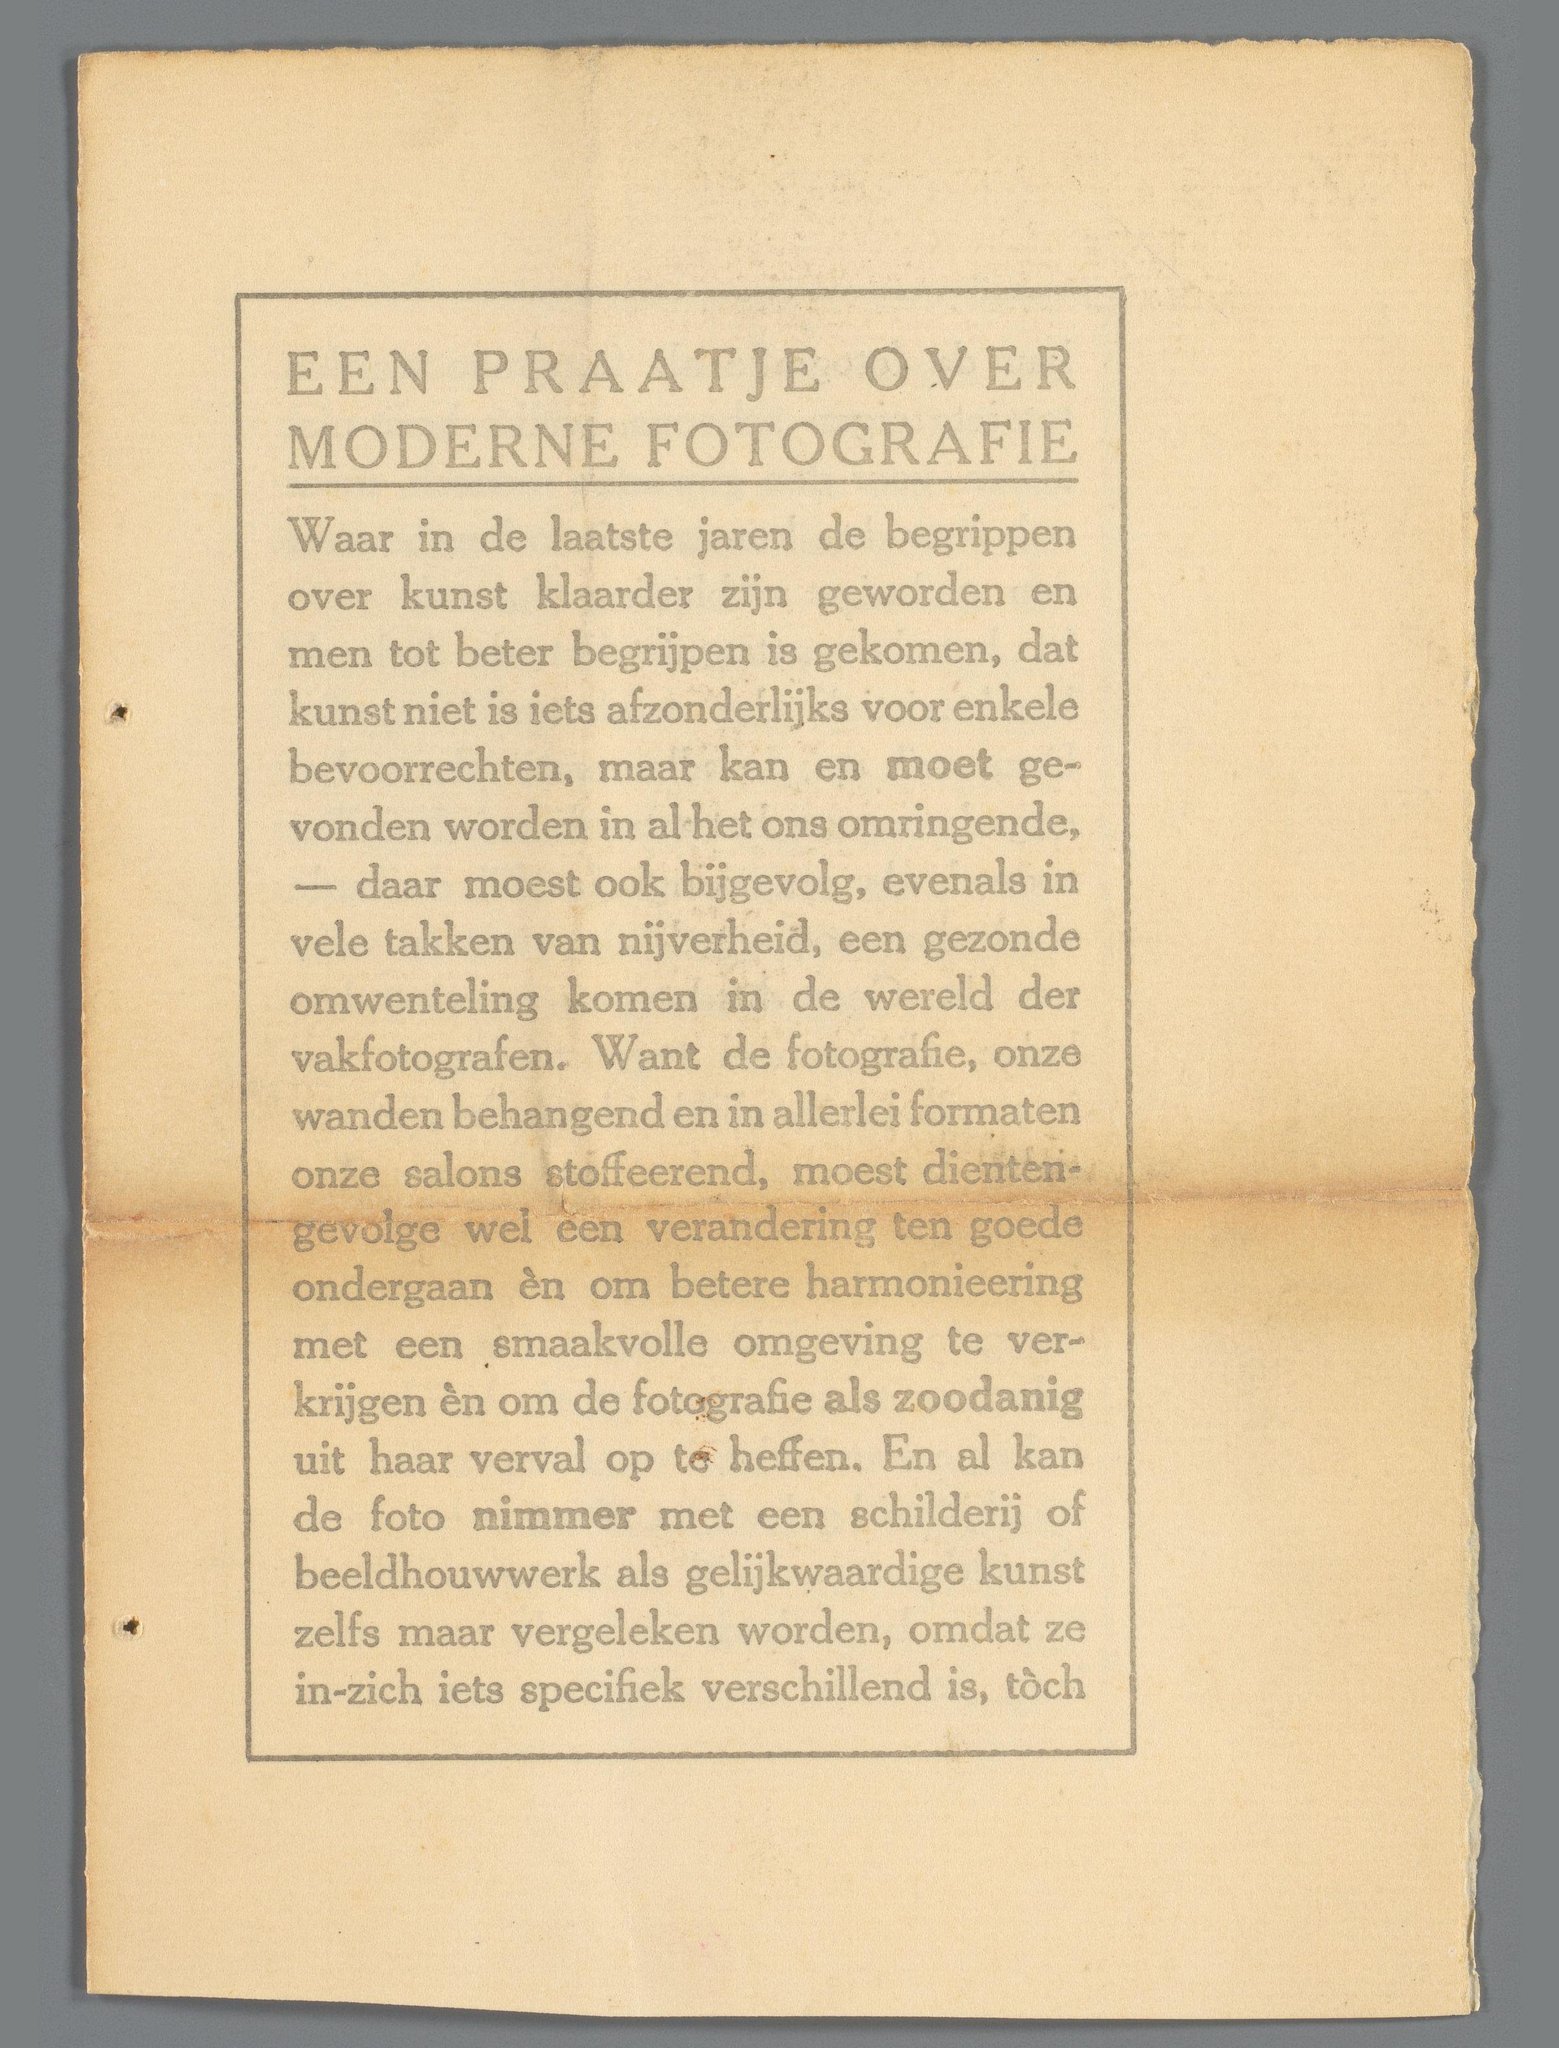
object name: document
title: Een praatje over moderne fotografie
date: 1909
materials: paper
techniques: letterpress printing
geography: amsterdam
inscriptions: watermark: ‘Van Gelder’